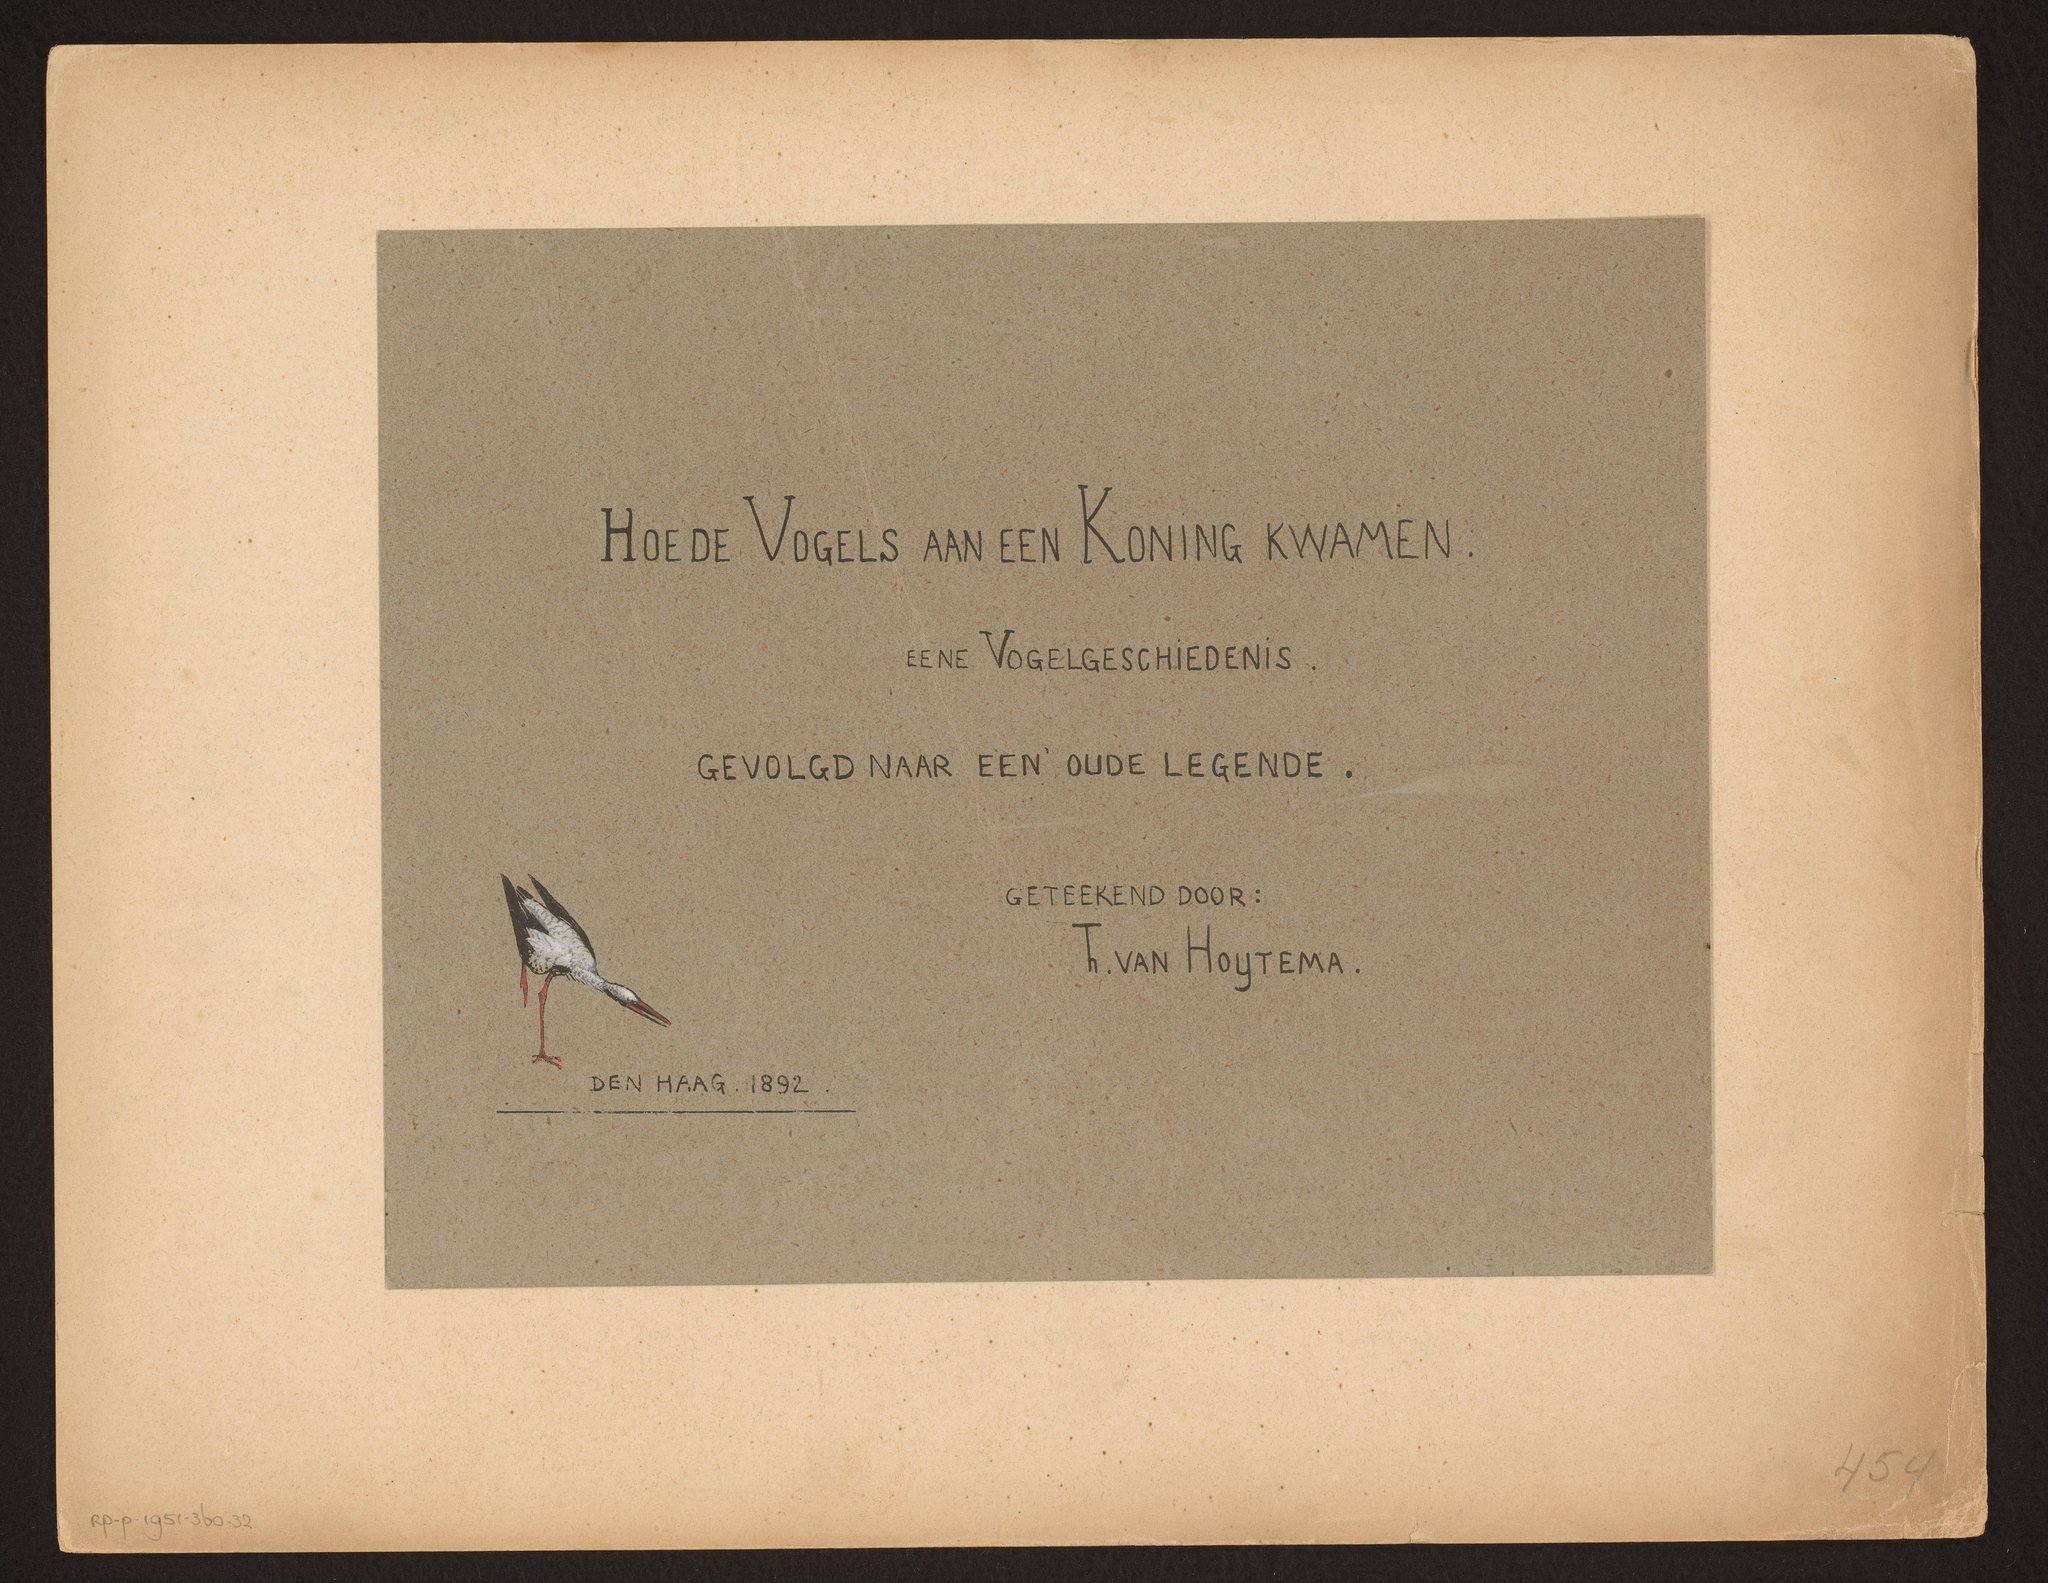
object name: print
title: Titelprent voor 'Hoe de vogels aan een koning kwamen'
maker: theo van hoytema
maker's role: draughtsman, painter, print maker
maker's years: 1863-1917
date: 1892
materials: paper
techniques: hand coloring, lithograph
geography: the hague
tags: shore-birds and wading-birds: stork, title-page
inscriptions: date